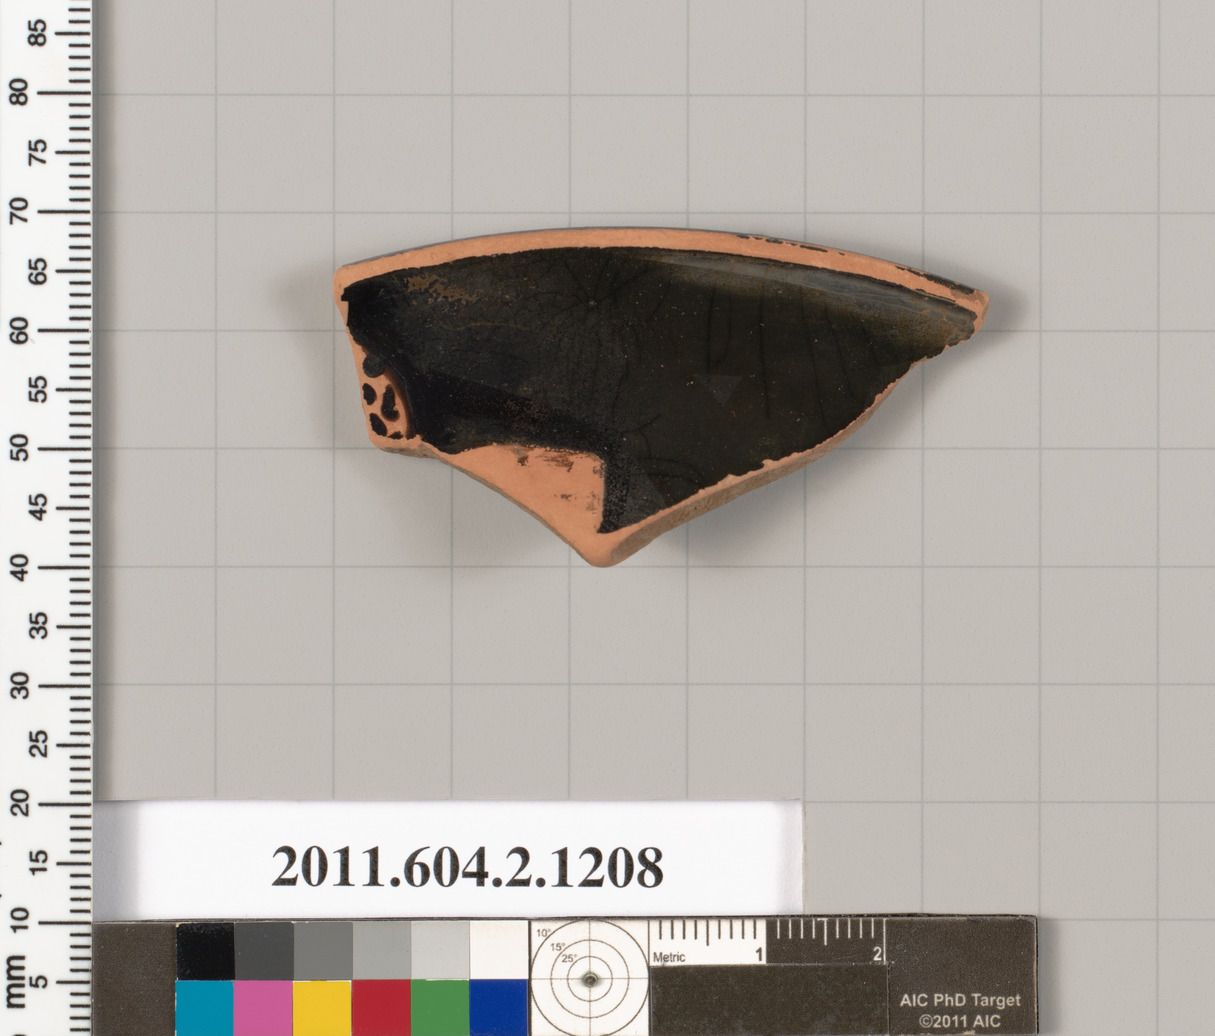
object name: kantharos fragment, head vase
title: Terracotta fragment from a kantharos: head vase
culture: greek, attic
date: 475-451 BCE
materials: terracotta